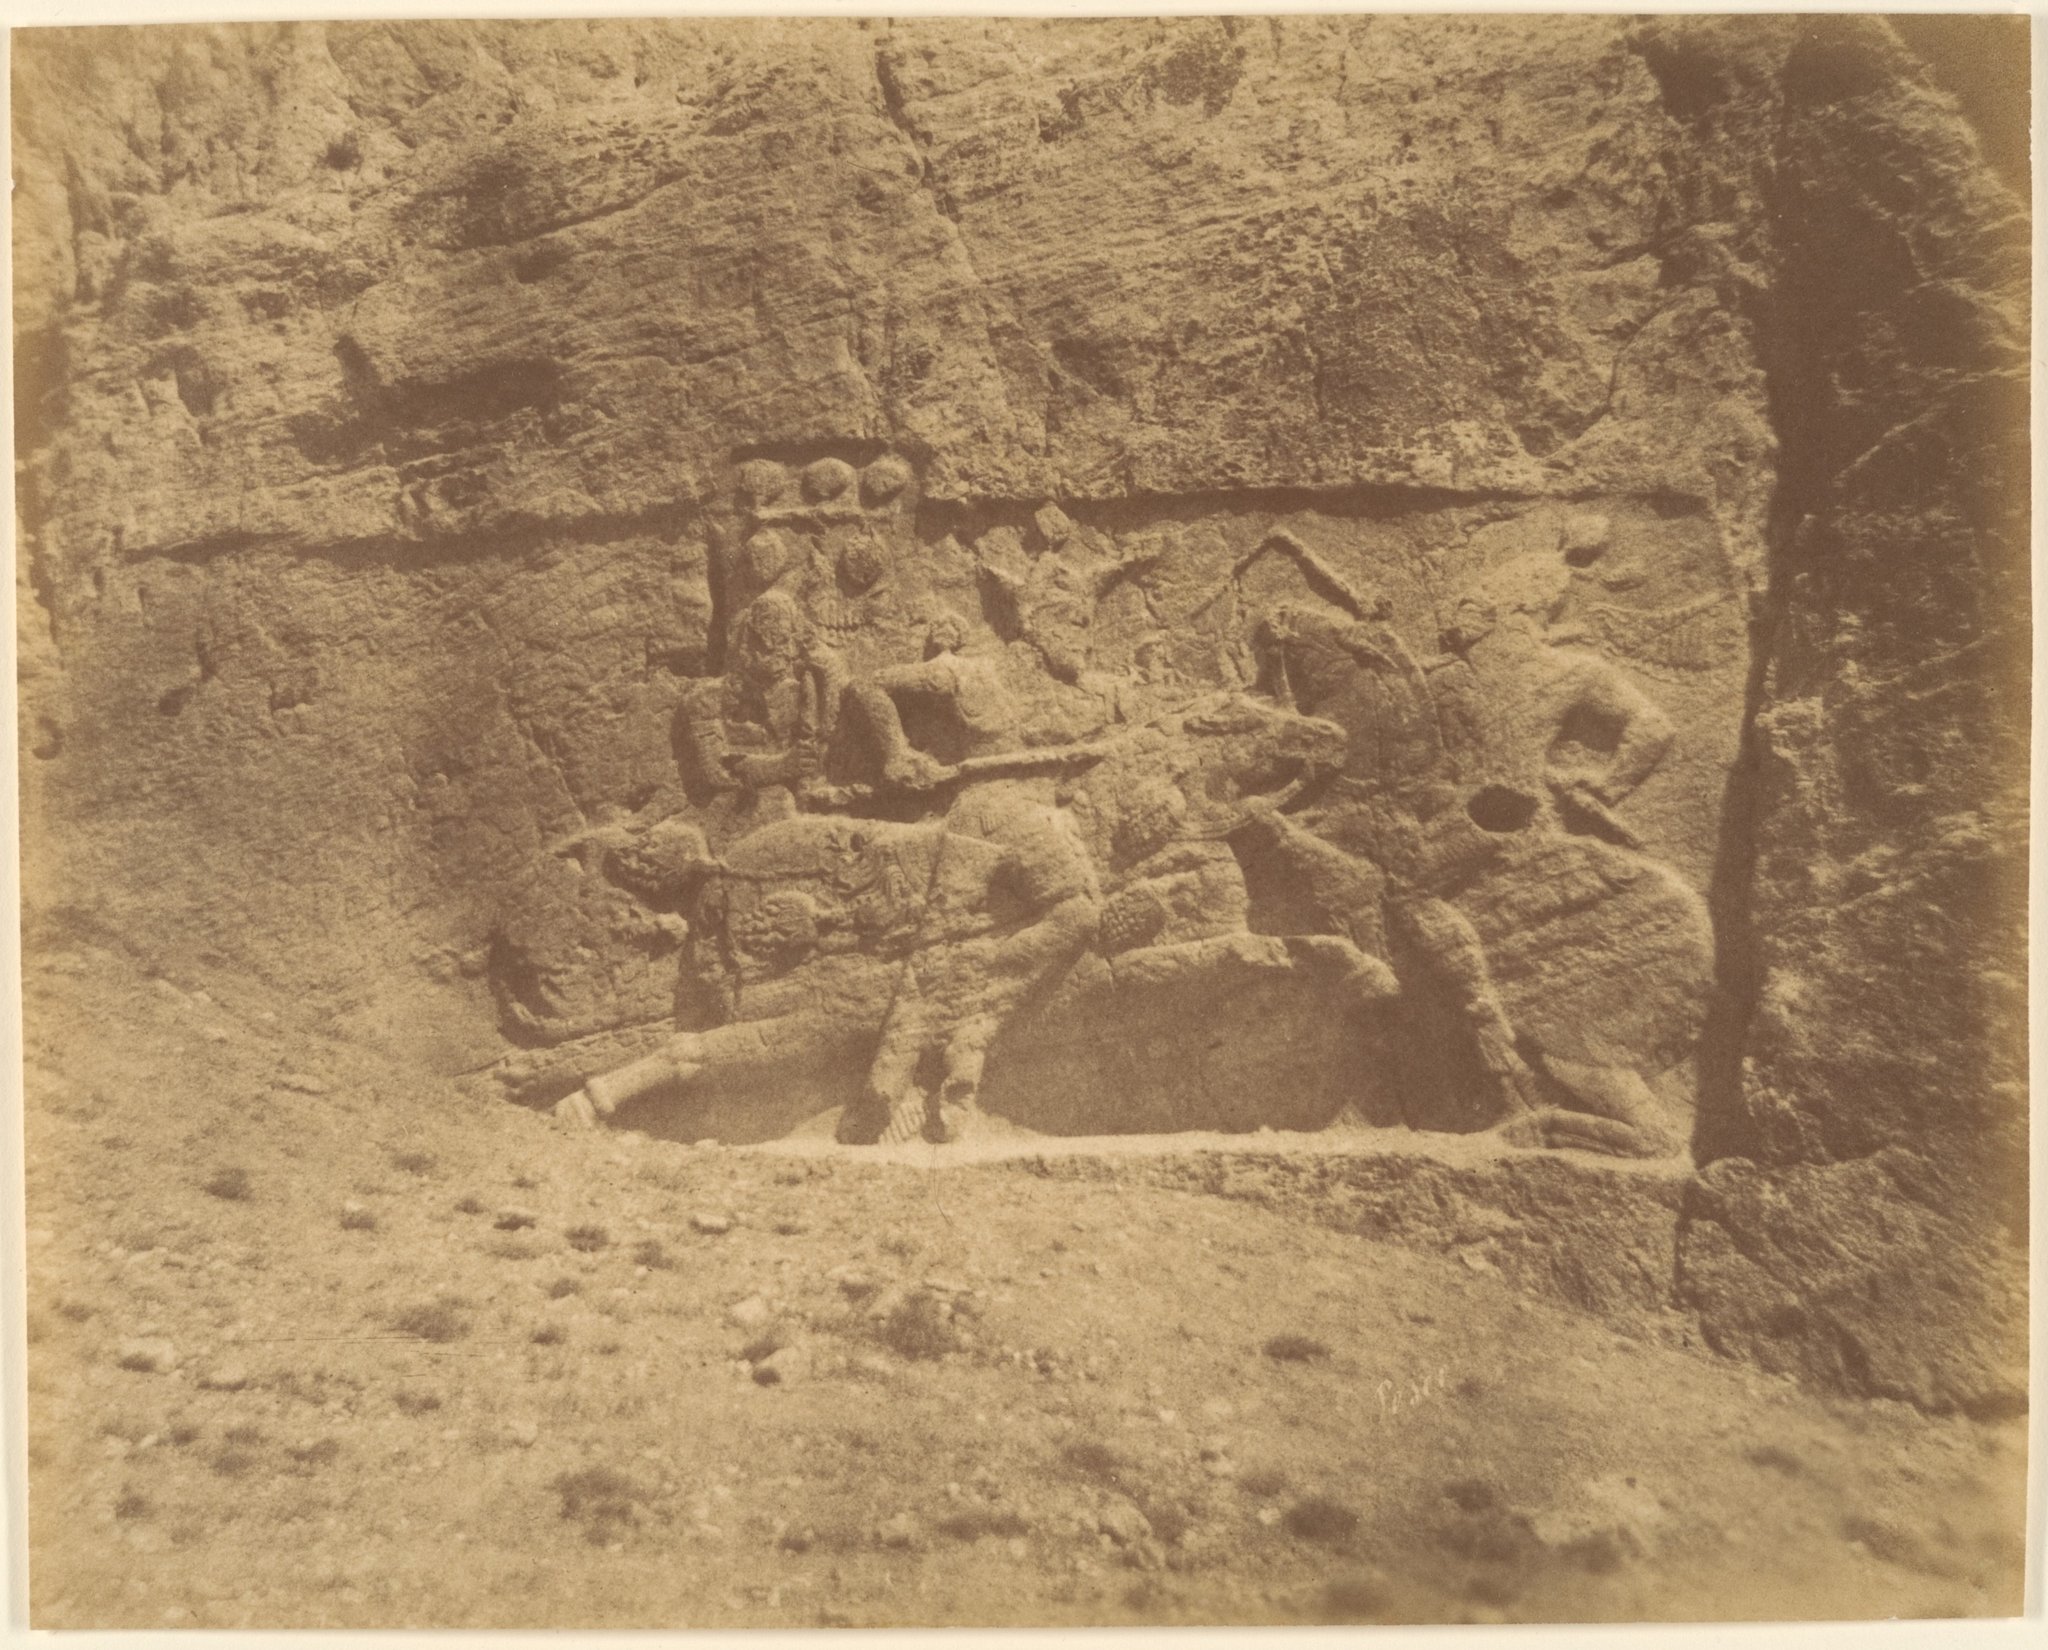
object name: photograph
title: (4) [Naksh-i Rustam, Near Persepolis]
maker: luigi pesce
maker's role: artist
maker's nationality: italian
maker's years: 1818-1891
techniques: albumen silver print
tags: men,horses